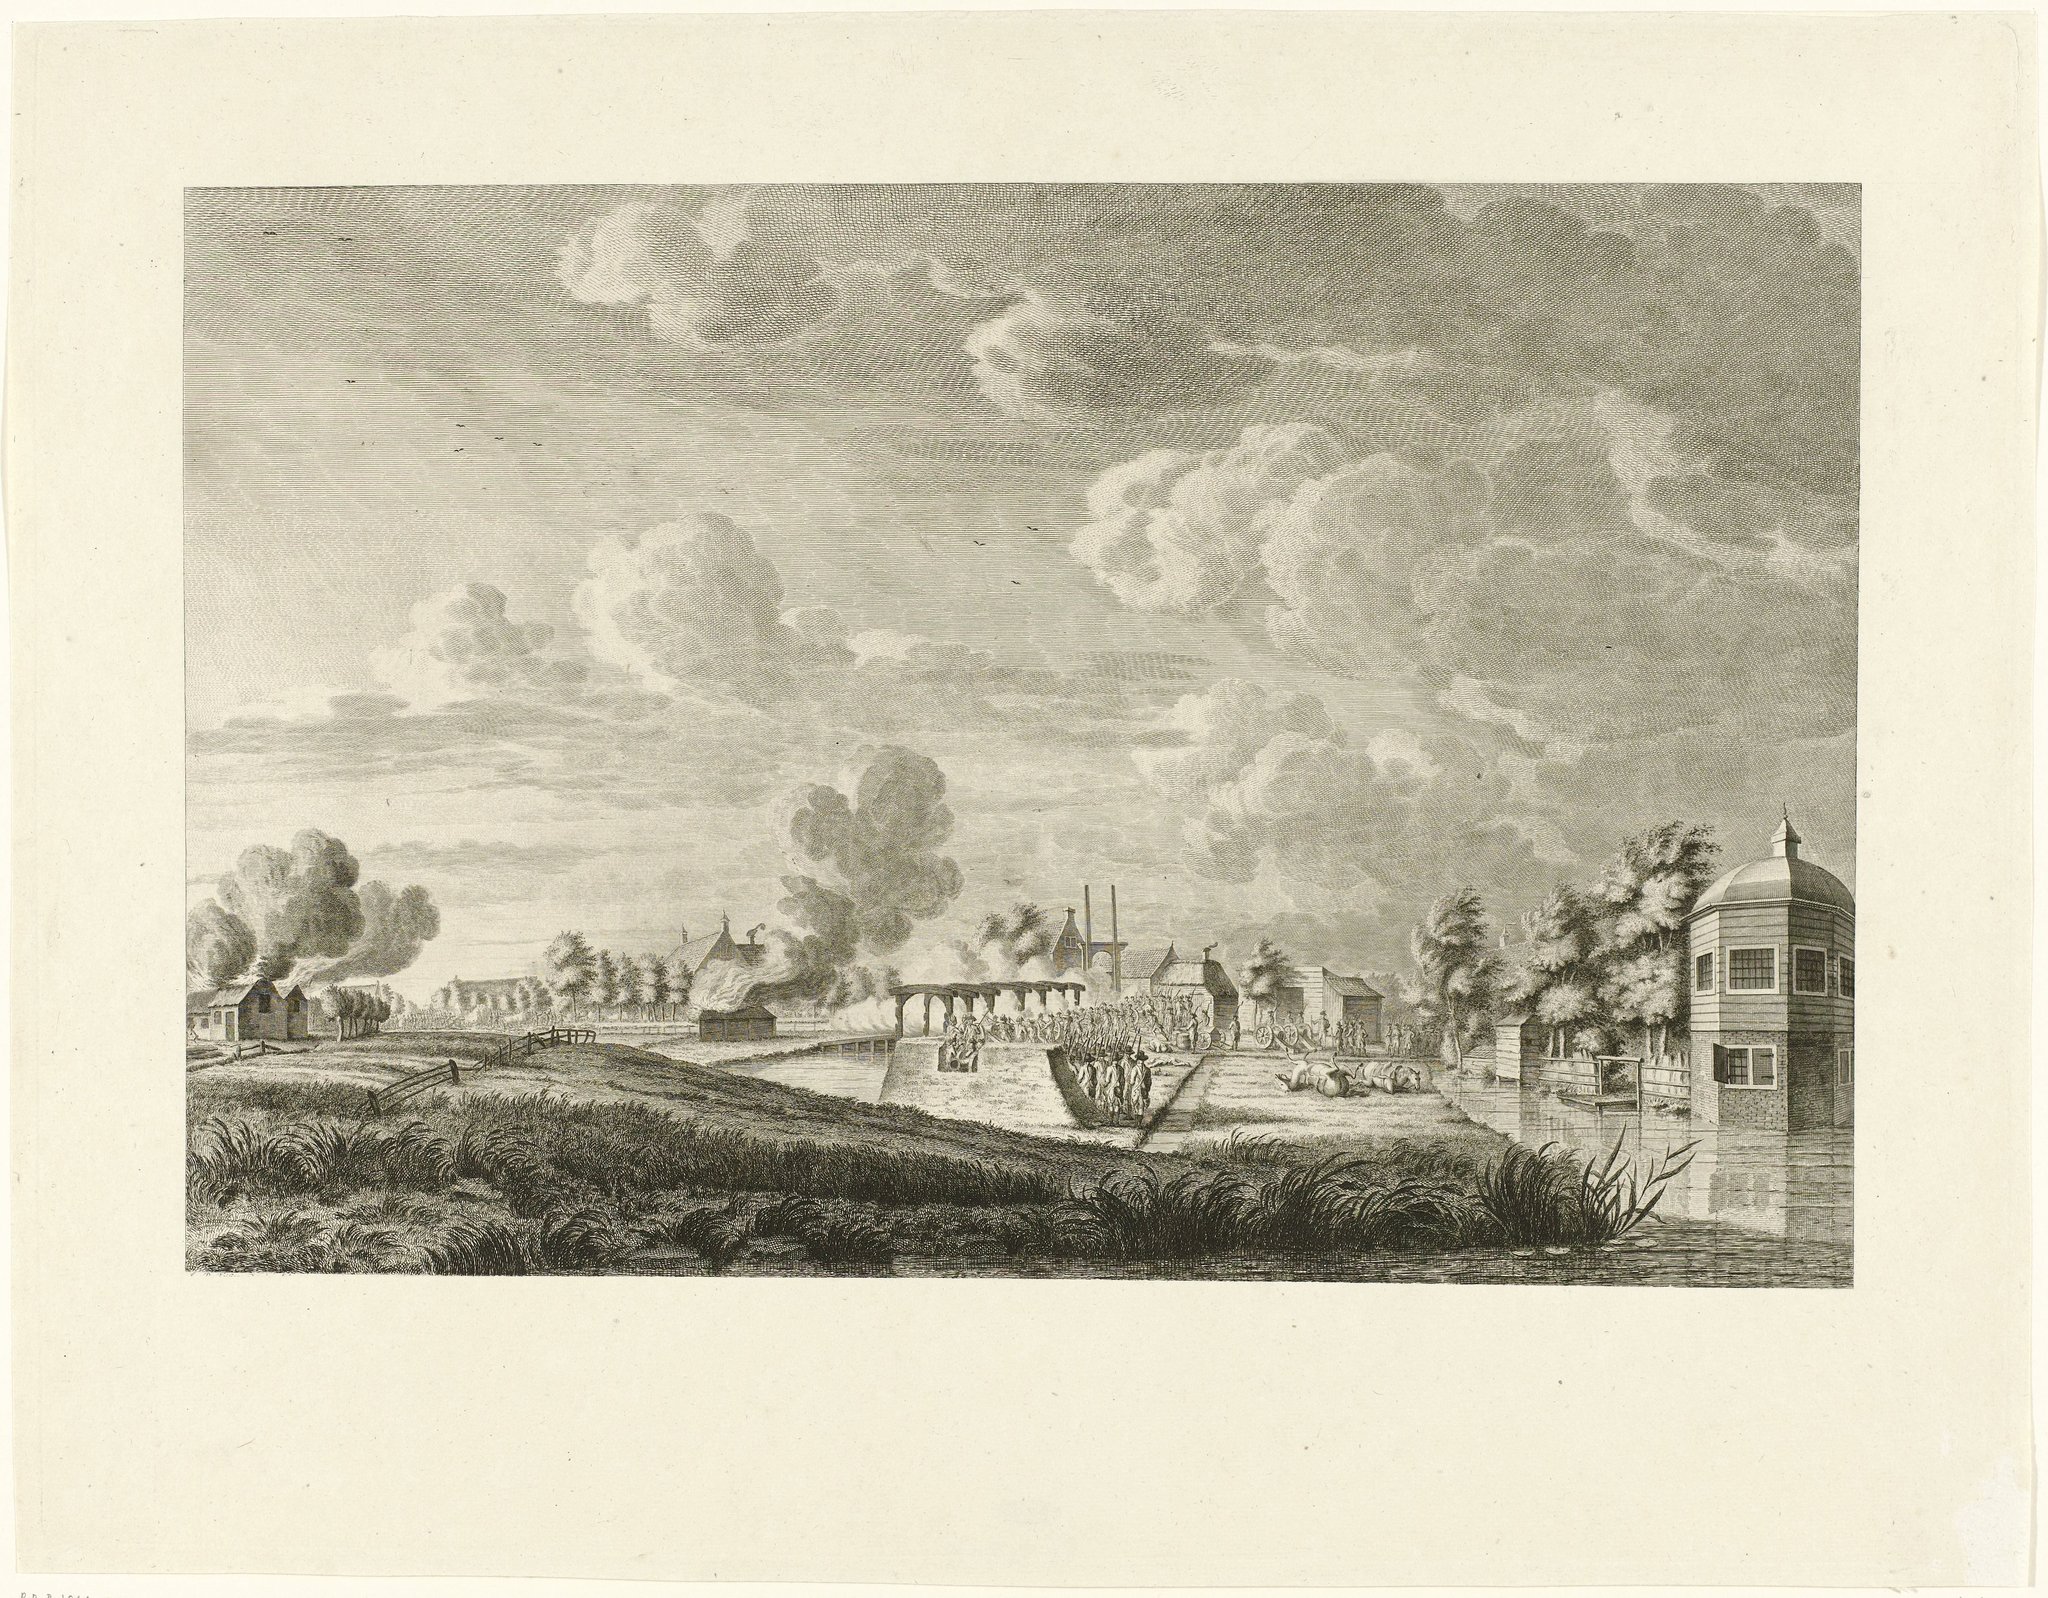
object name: print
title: Gevechten met de Pruisische troepen rond Amsterdam in 1787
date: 1791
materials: paper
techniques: engraving, etching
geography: northern netherlands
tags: karel willem ferdinand hertog van brunswijk-wolfenbüttel, (military) attack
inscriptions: collector's mark: Lugt 2228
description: Aanval op de stad Amstelveen door de Pruisische troepen onder commando van de hertog van Brunswijk, verdedigd door Amsterdamse schutters onder kolonel Grave des Portes, 1 oktober 1787. Onderdeel van een groep van zeven prenten van de gevechten met de Pruissische troepen rond Amsterdam in 1787.